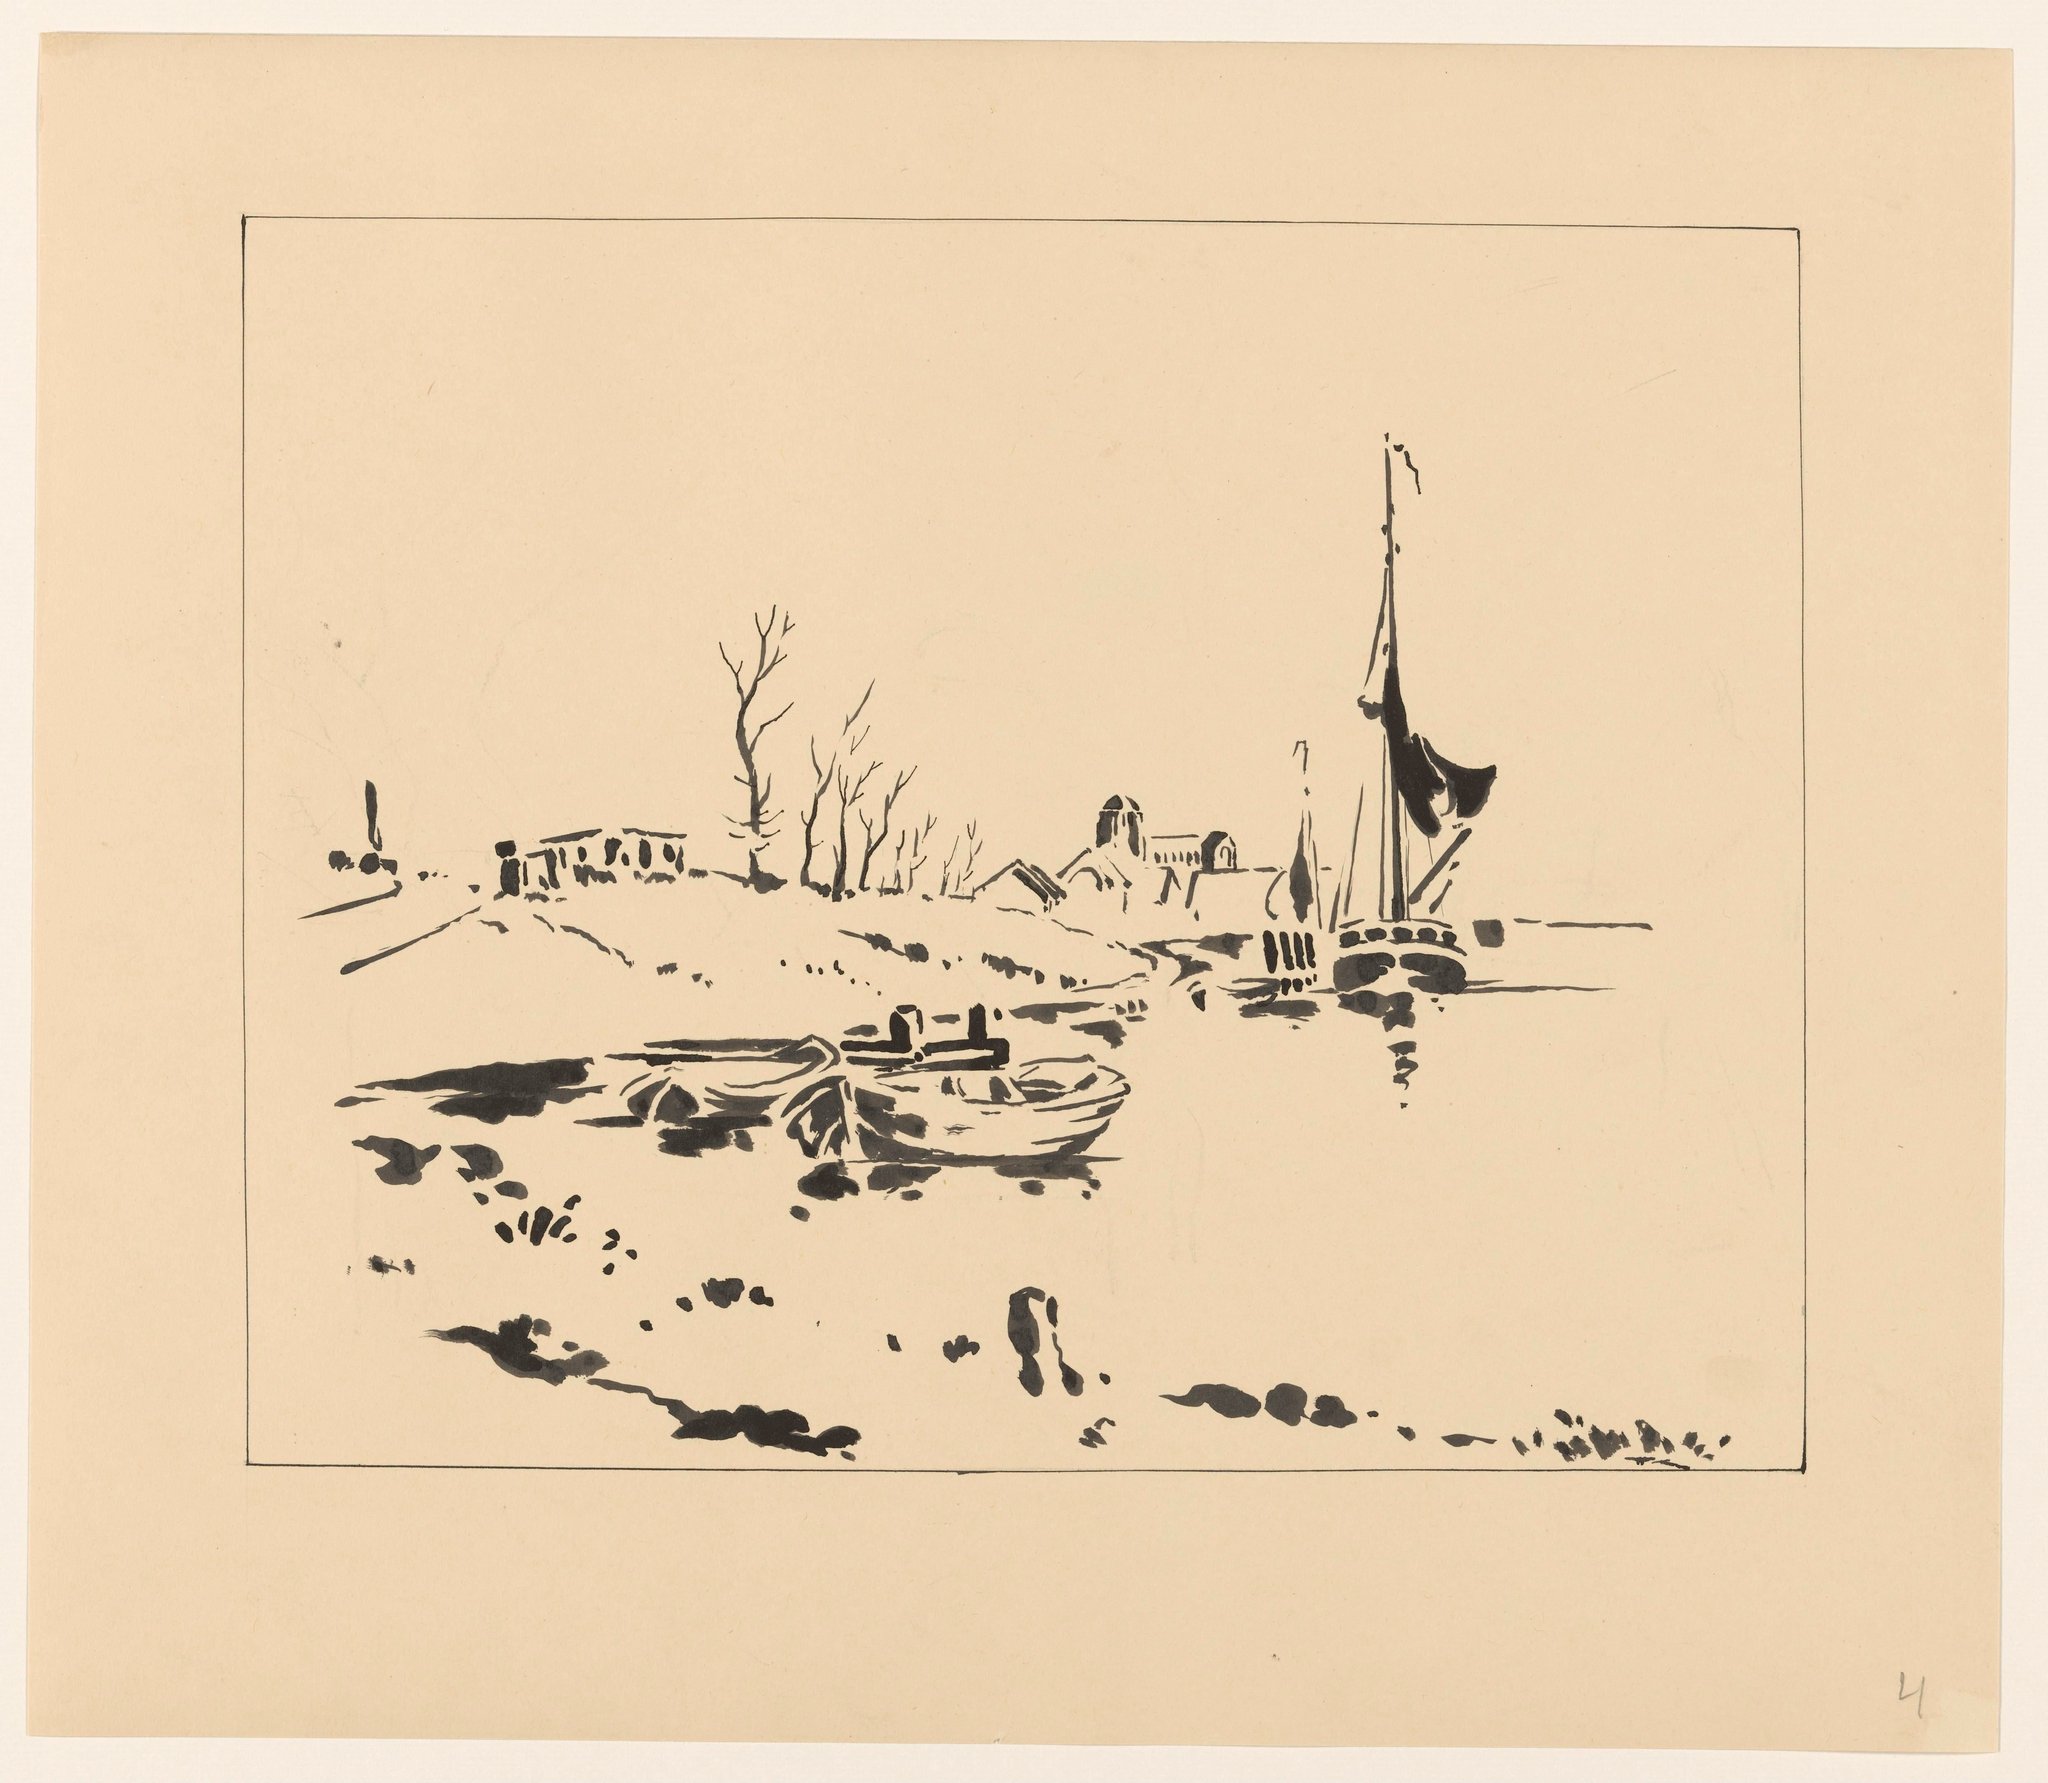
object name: drawing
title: De haven en de Grote Kerk te Veere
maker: johannes frederik engelbert ten klooster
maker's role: draughtsman, print maker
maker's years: 1873-1940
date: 1883-1940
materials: paper, pencil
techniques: brush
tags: boat or vehicle drawn by (fabulous) animal(s) of the sea, church (exterior)